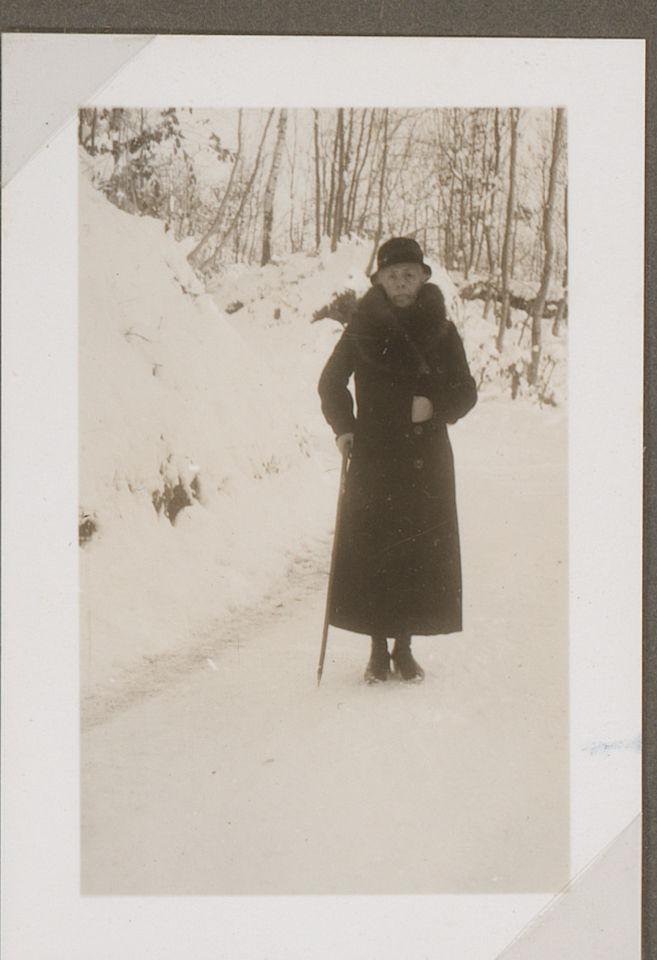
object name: photograph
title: Vrouw op de weg tussen Cagiallo en Oggio, Zwitserland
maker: Anonymous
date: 1933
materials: photographic support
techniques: gelatin silver print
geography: capriasca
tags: historical persons - bb - woman, road, path, snow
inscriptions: number: ‘21’